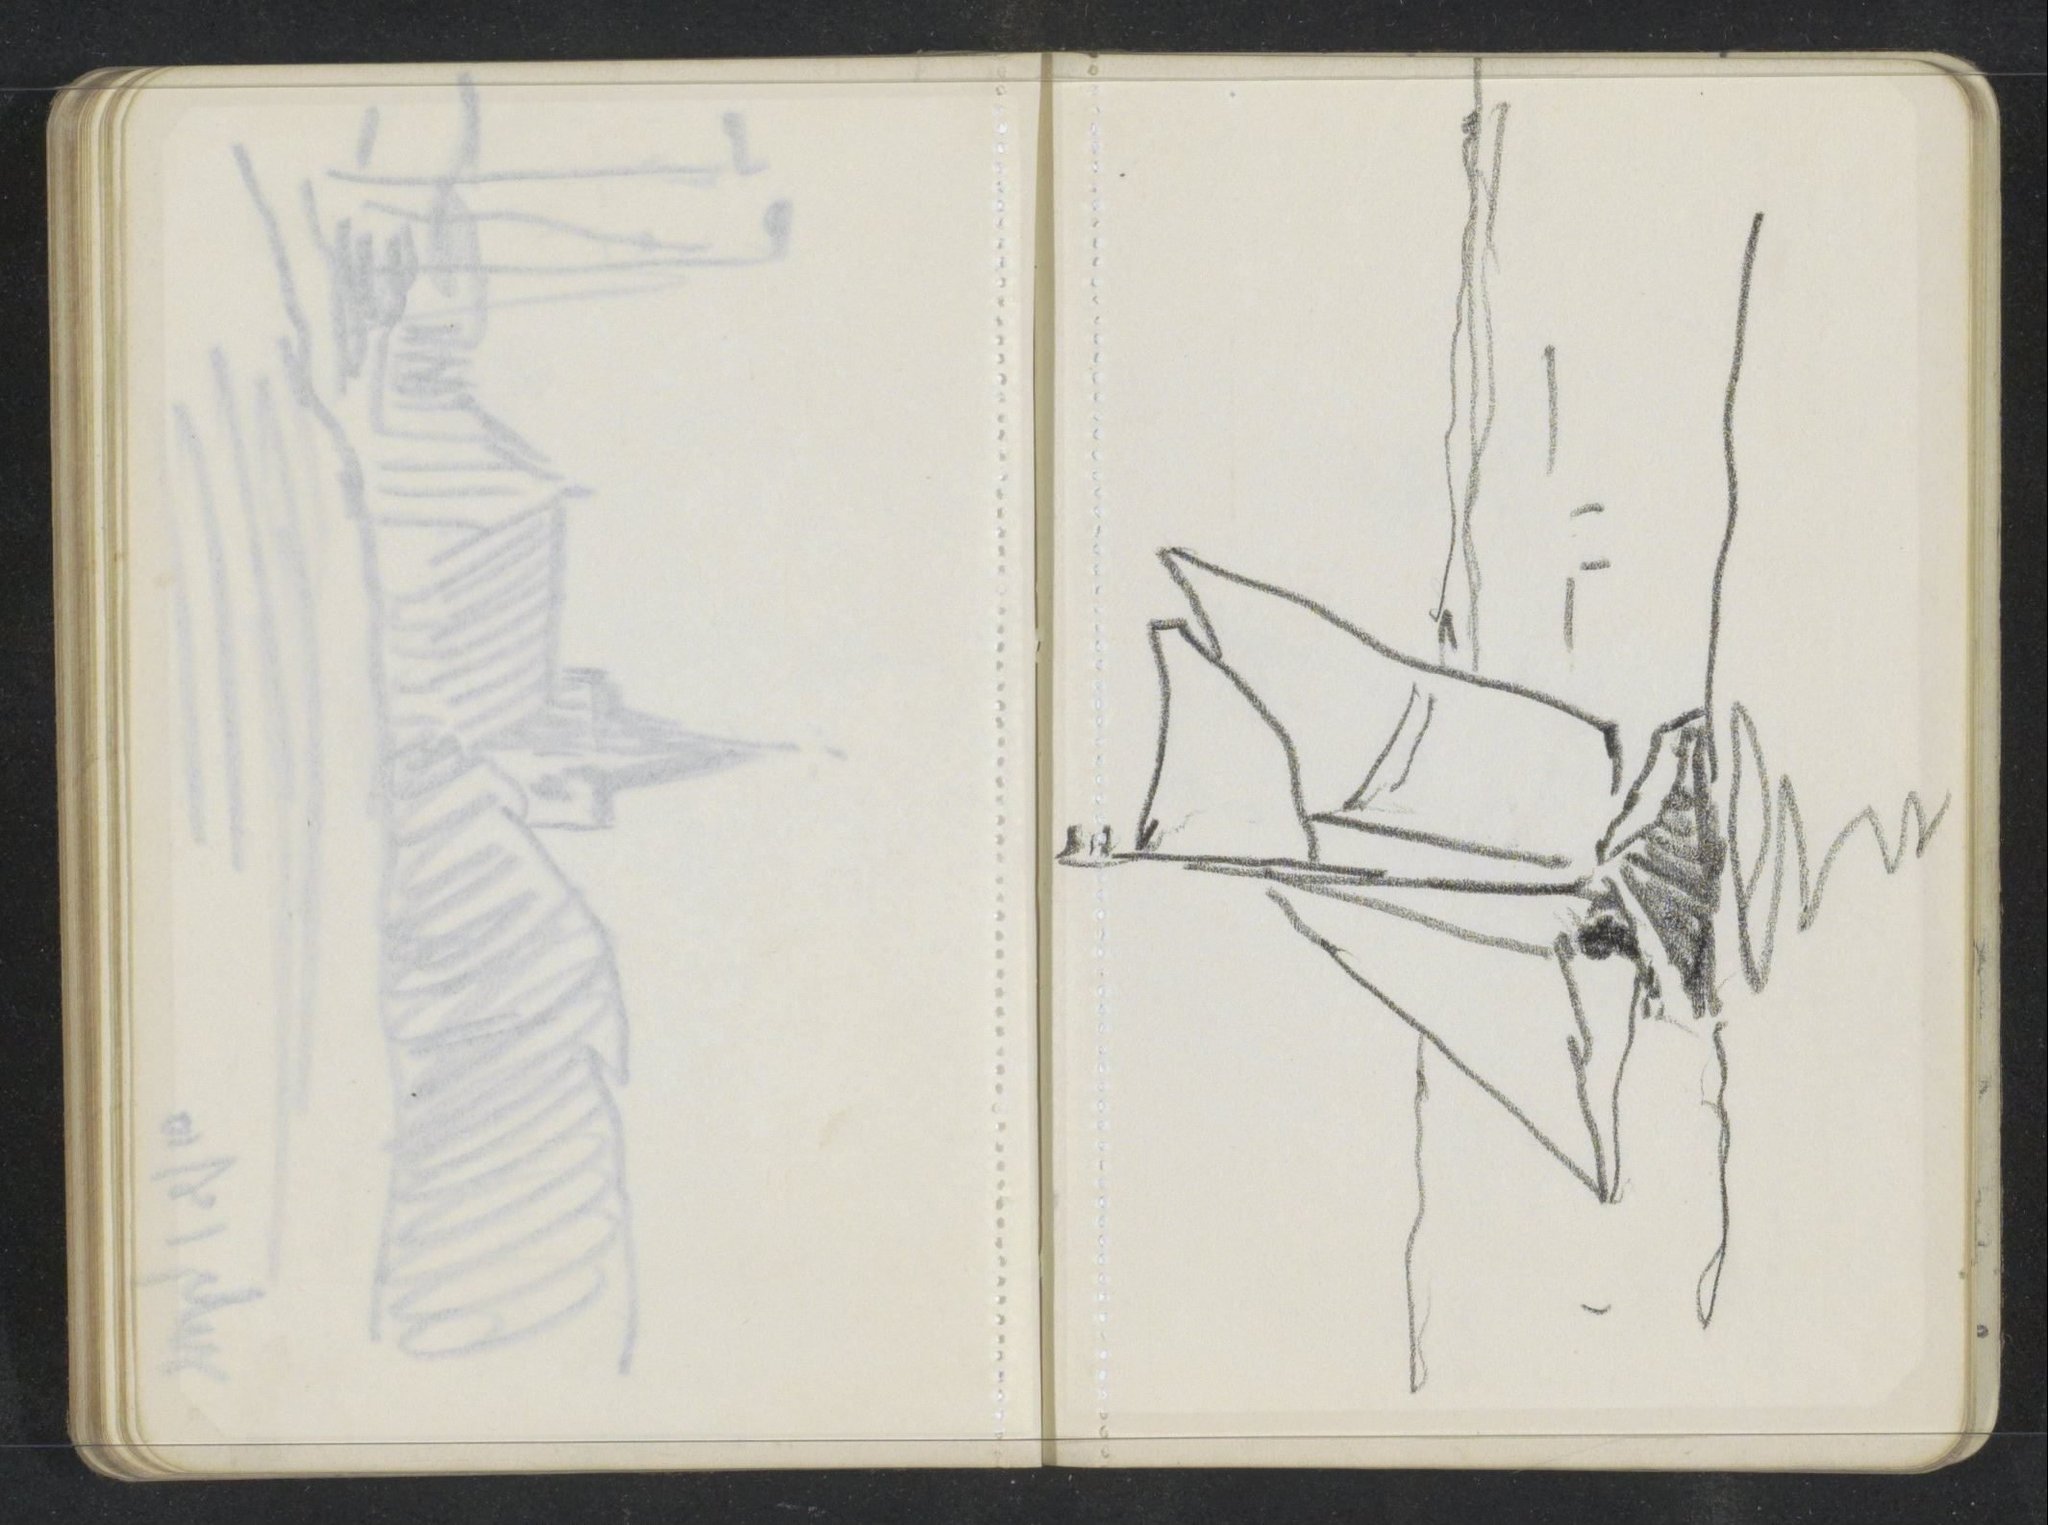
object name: sketchbook leaf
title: Zeilboot op het water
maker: alexander shilling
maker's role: draughtsman, print maker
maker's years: 1859-1937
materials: paper, pencil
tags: sailing-ship, sailing-boat, landscapes with waters, waterscapes, seascapes (in the temperate zone)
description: Blad 52 recto uit een schetsboek met 91 bladen.